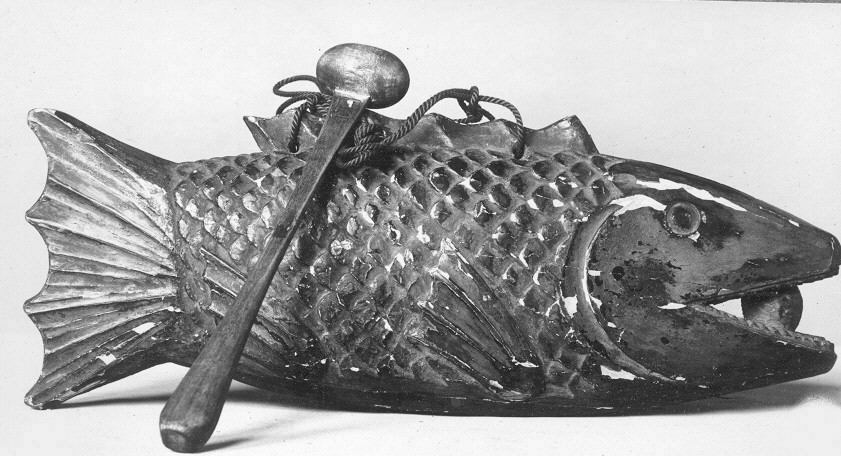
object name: hanteki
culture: japanese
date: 1867-1900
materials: wood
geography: japan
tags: fish